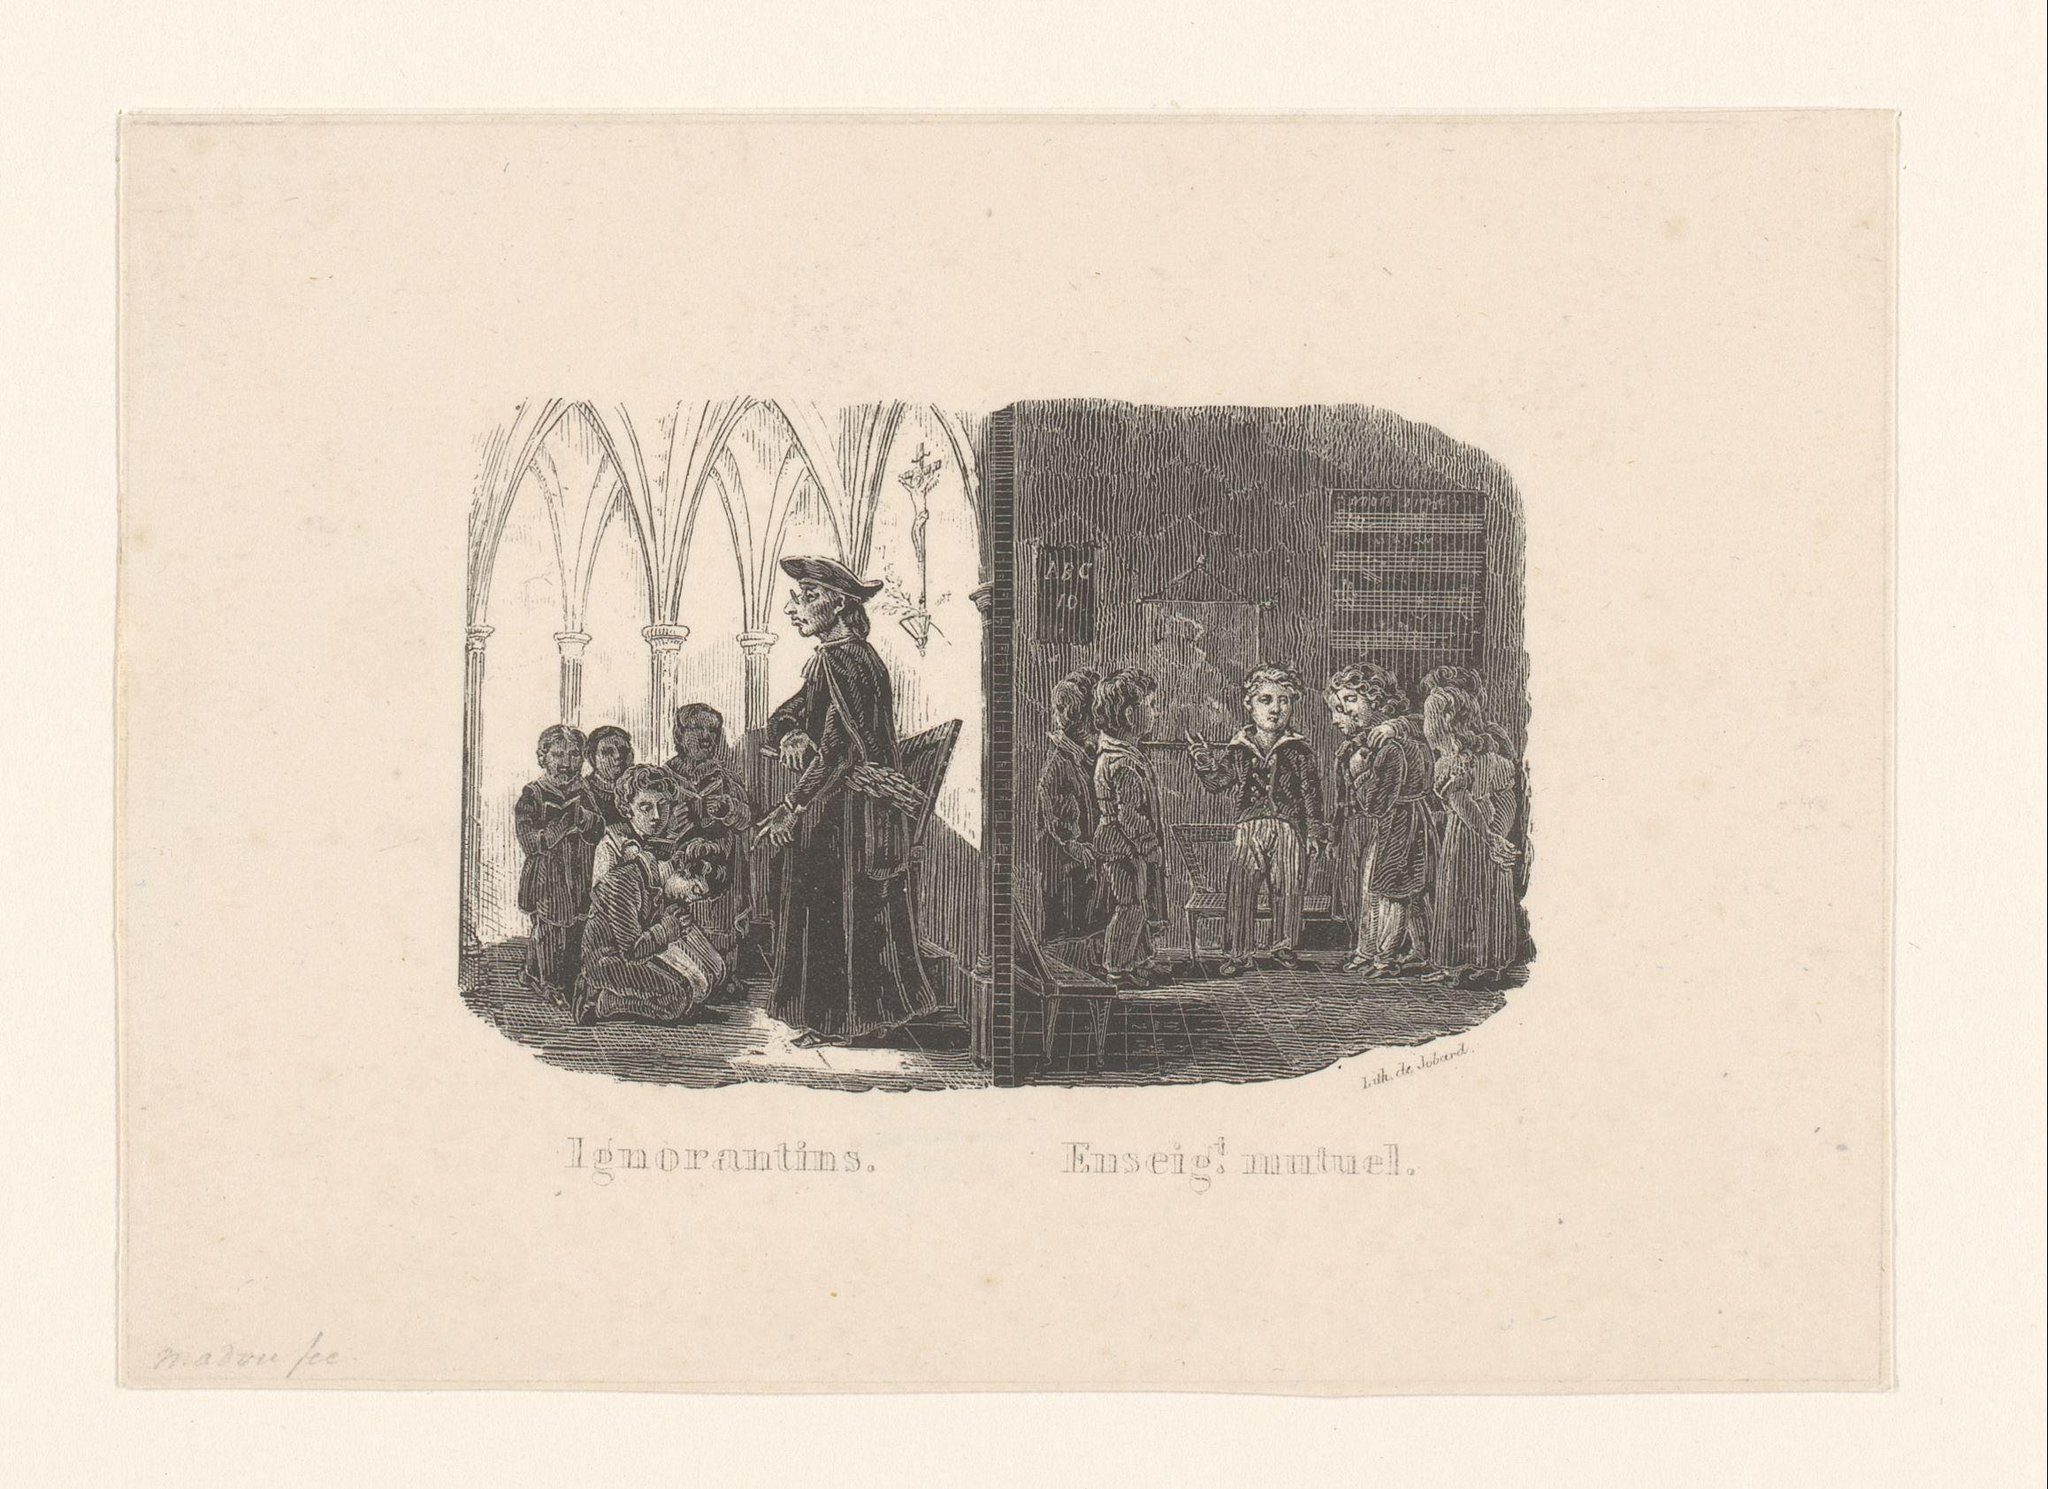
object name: cartoon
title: Geestelijke onderwijst een groep kinderen en kinderen onderwijzen elkaar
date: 1819-1834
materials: paper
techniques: lithograph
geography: brussels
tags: symbolic representations, allegories and emblems ~ education; 'ammaestramento', dottrina', 'educatione', 'istitutione' (ripa), scholastic education, tuition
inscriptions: collector's mark: Lugt 2228